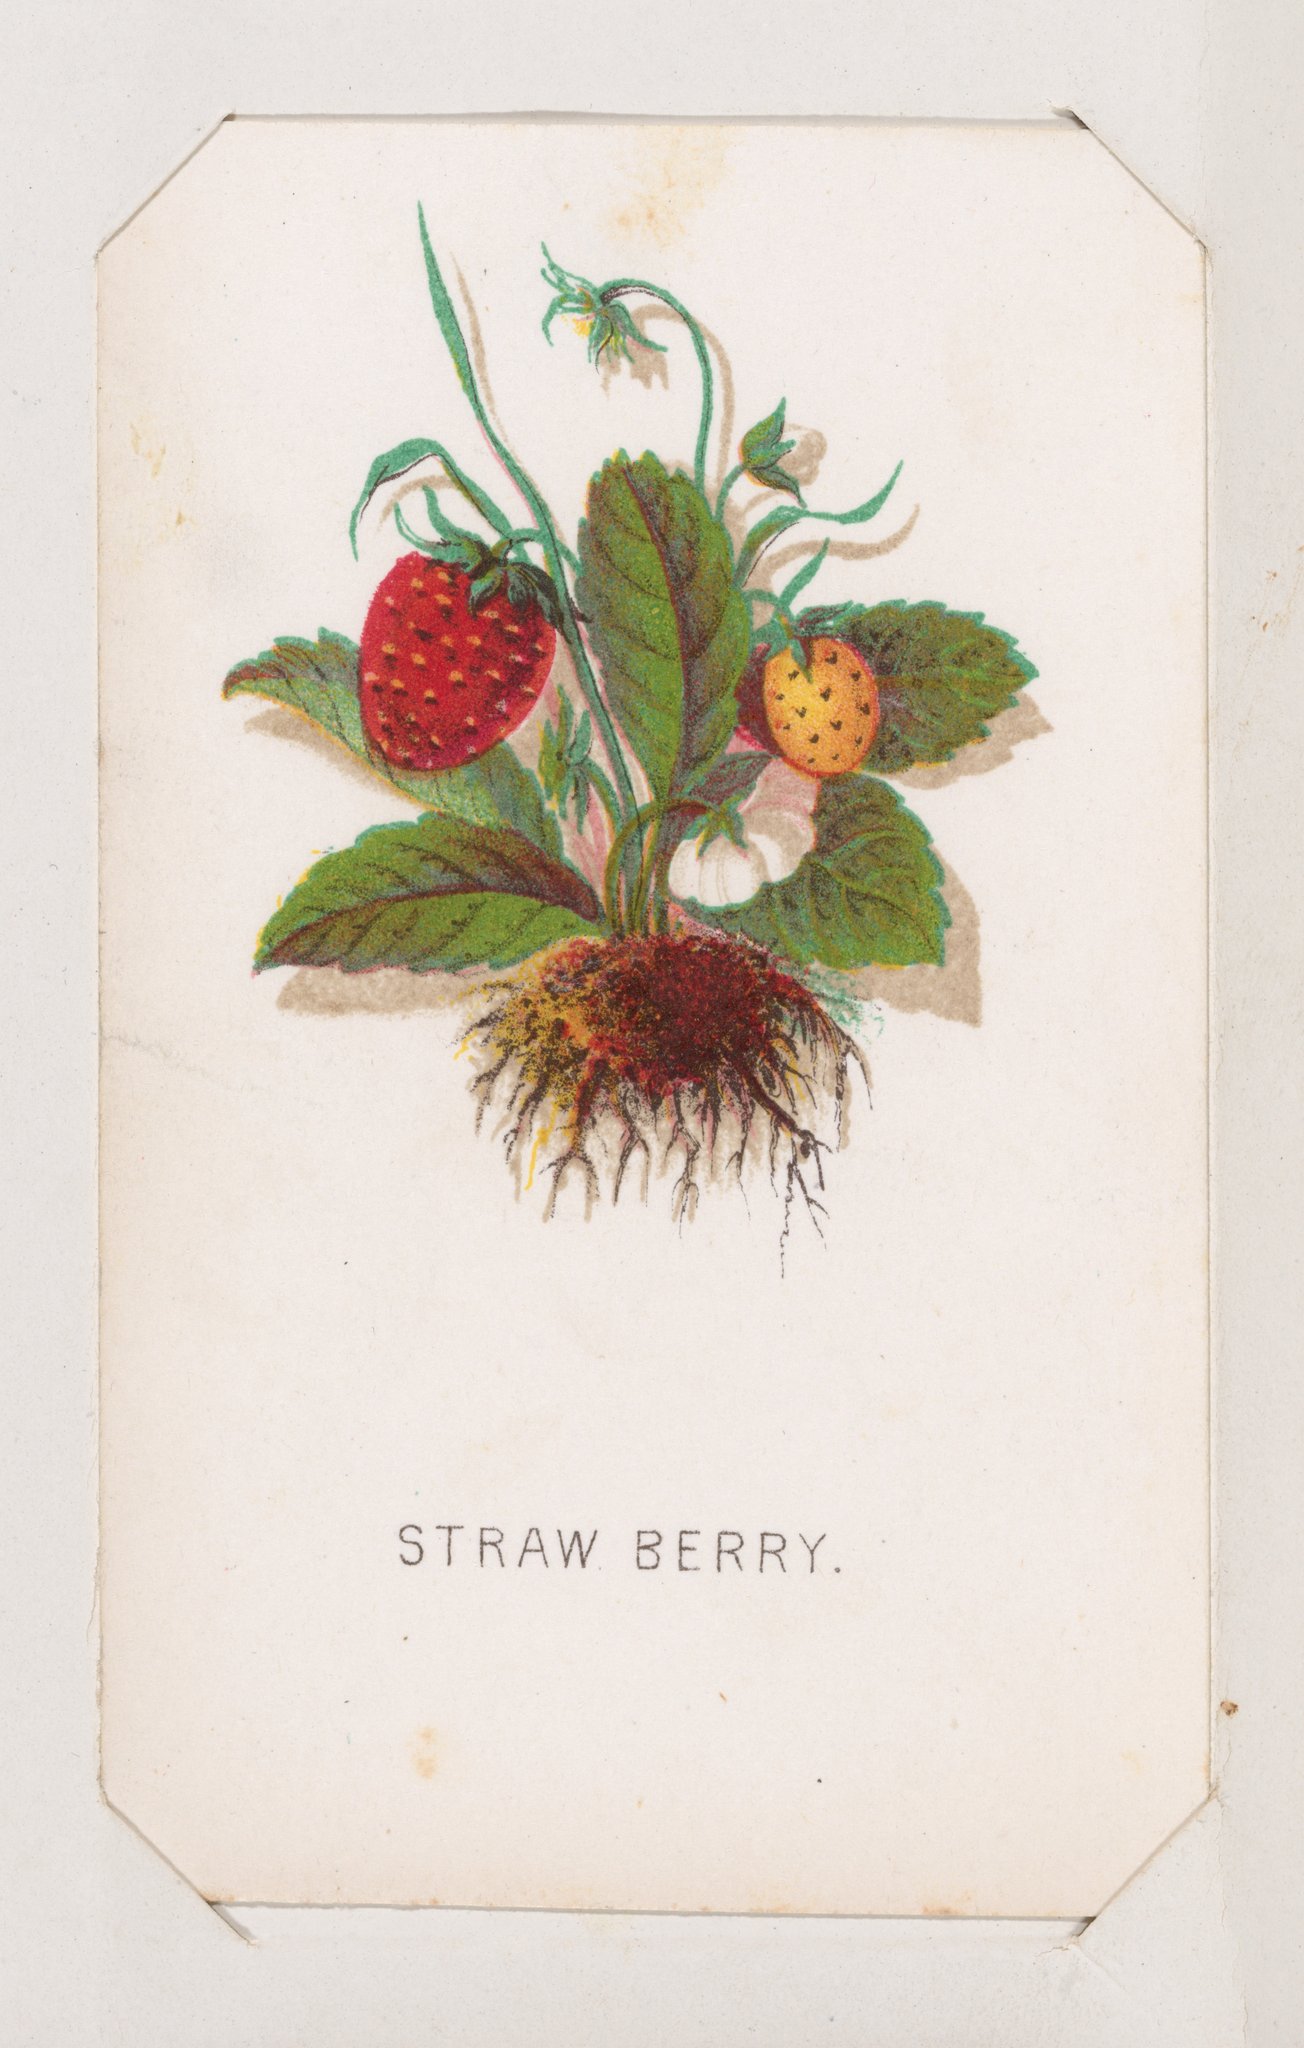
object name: album card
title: Straw Berry card from the Plant with Root series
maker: louis prang & co.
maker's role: publisher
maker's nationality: american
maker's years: 1800-1950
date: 1862-1869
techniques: lithograph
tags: plants